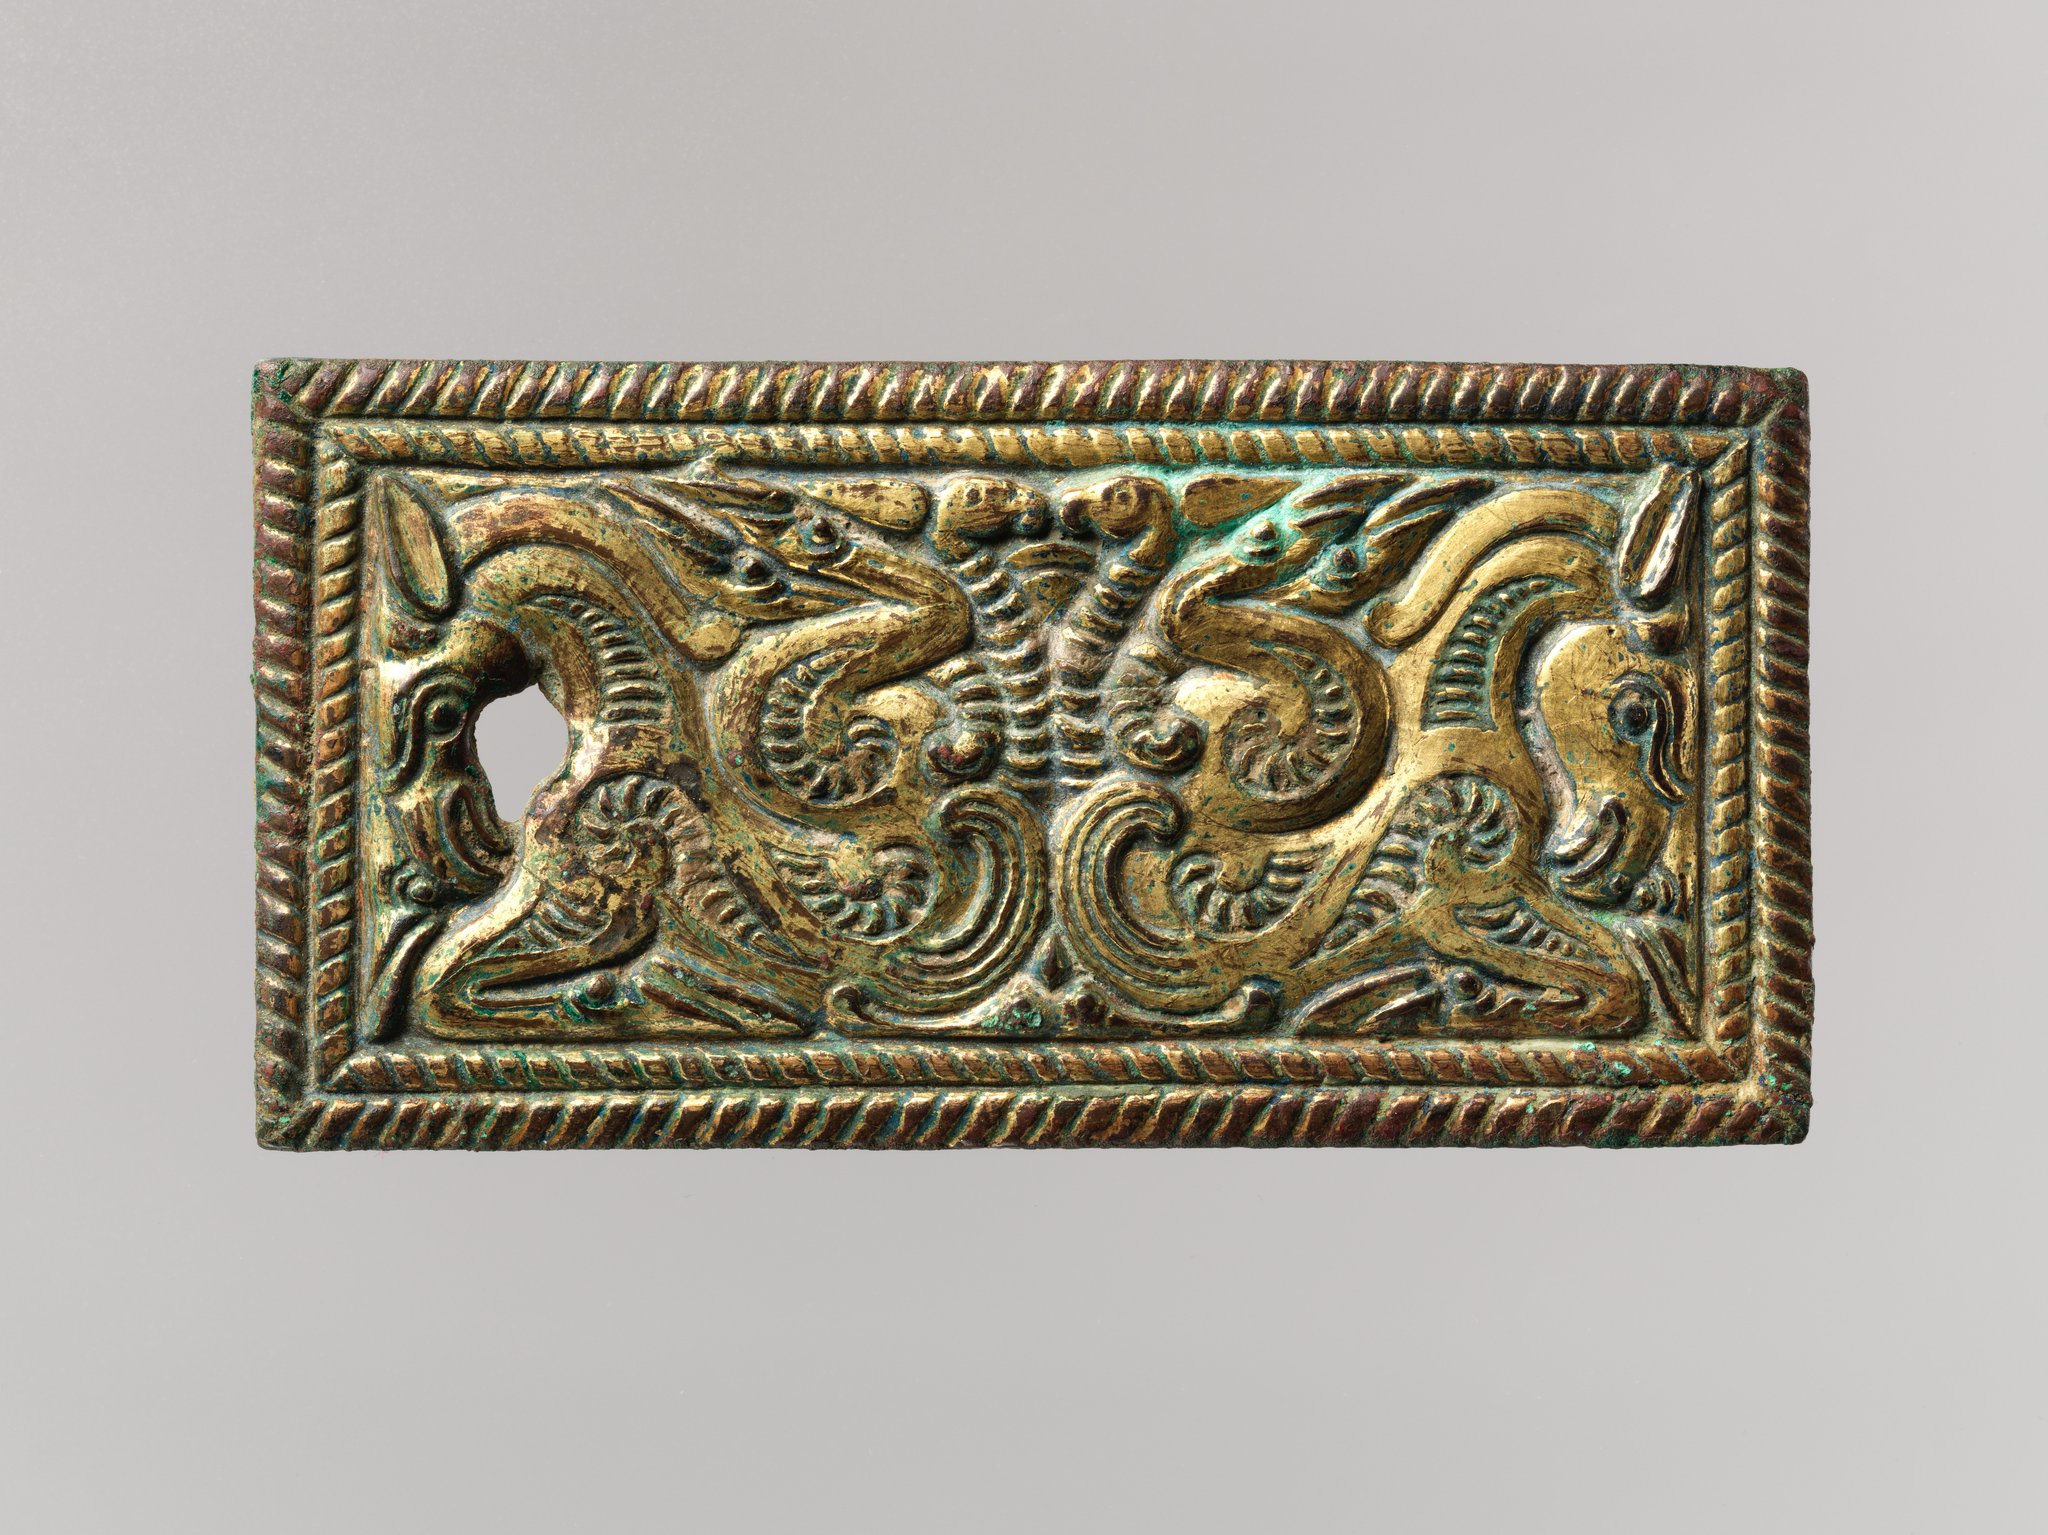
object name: belt buckle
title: Belt Buckle with Beaked Ungulates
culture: north chinese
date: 200-101 BCE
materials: bronze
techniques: gilding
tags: animals